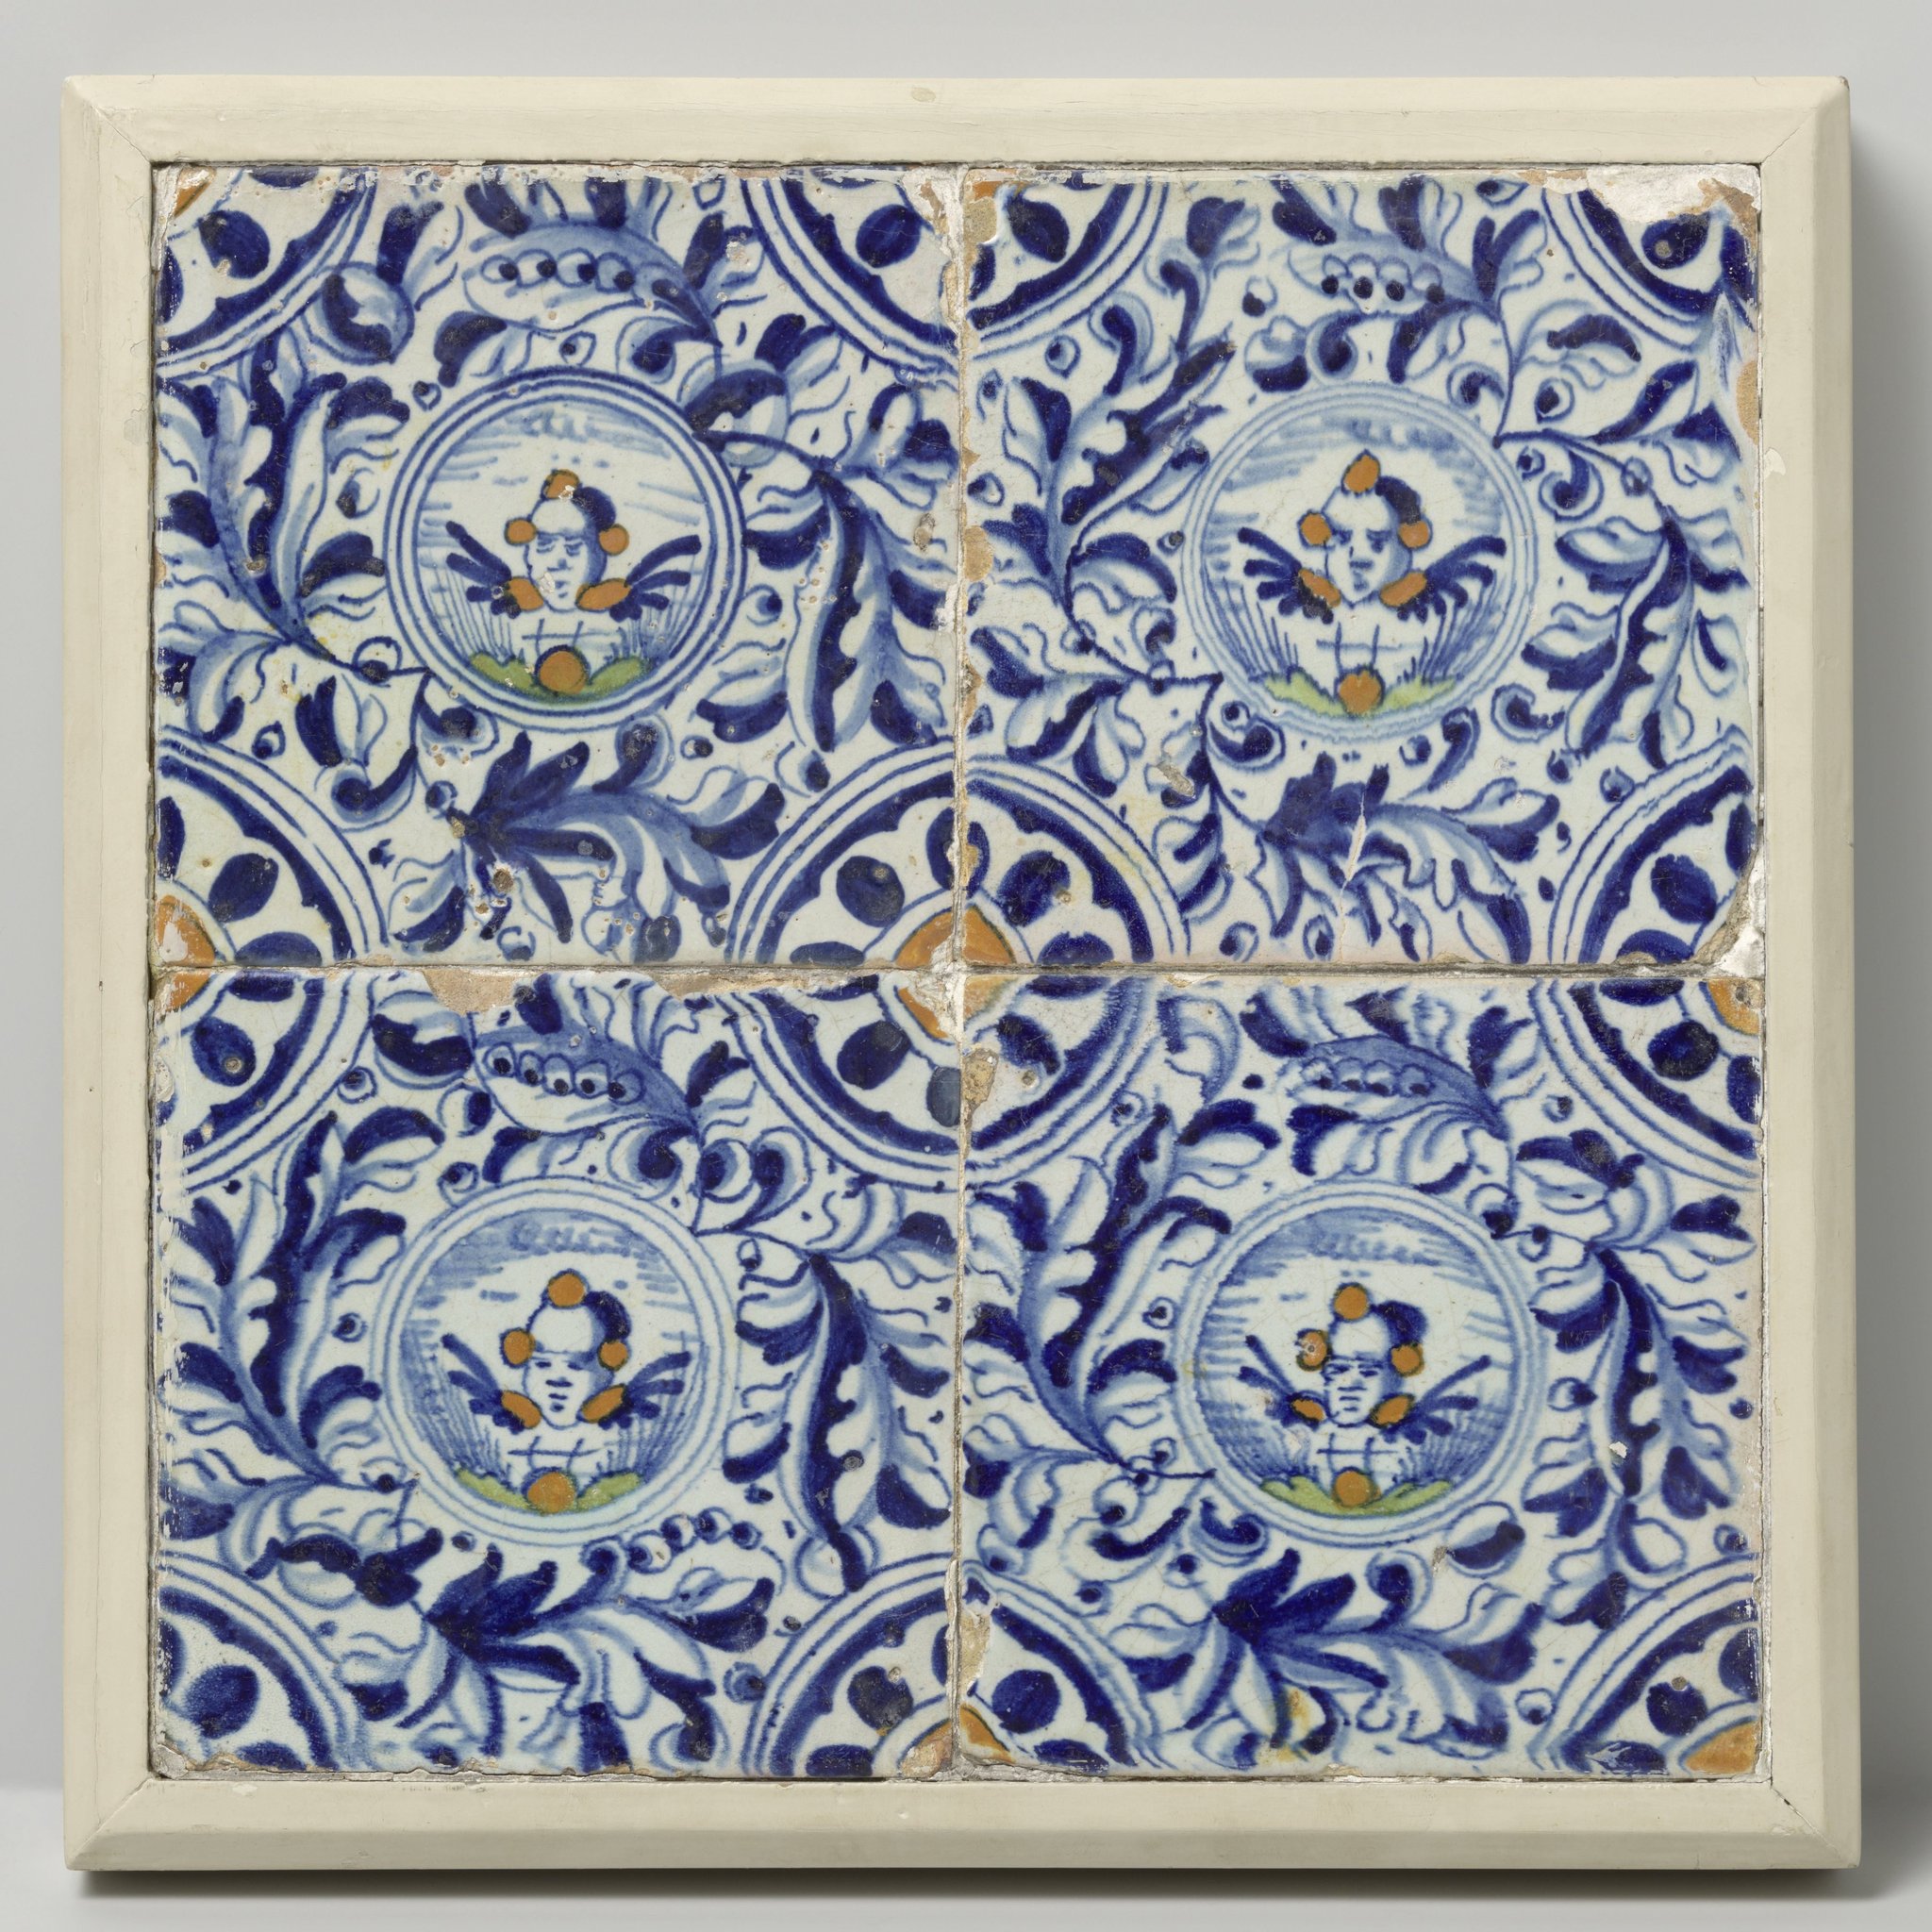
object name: tile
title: Veld van vier tegels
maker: Anonymous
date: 1615-1625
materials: earthenware, glaze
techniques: maiolica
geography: netherlands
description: Veld van 4 tegels (2 x 2) elk met een blauw geschilderd cherubkopje binnen een cirkel met lof. In de hoeken, een kwart rozet.